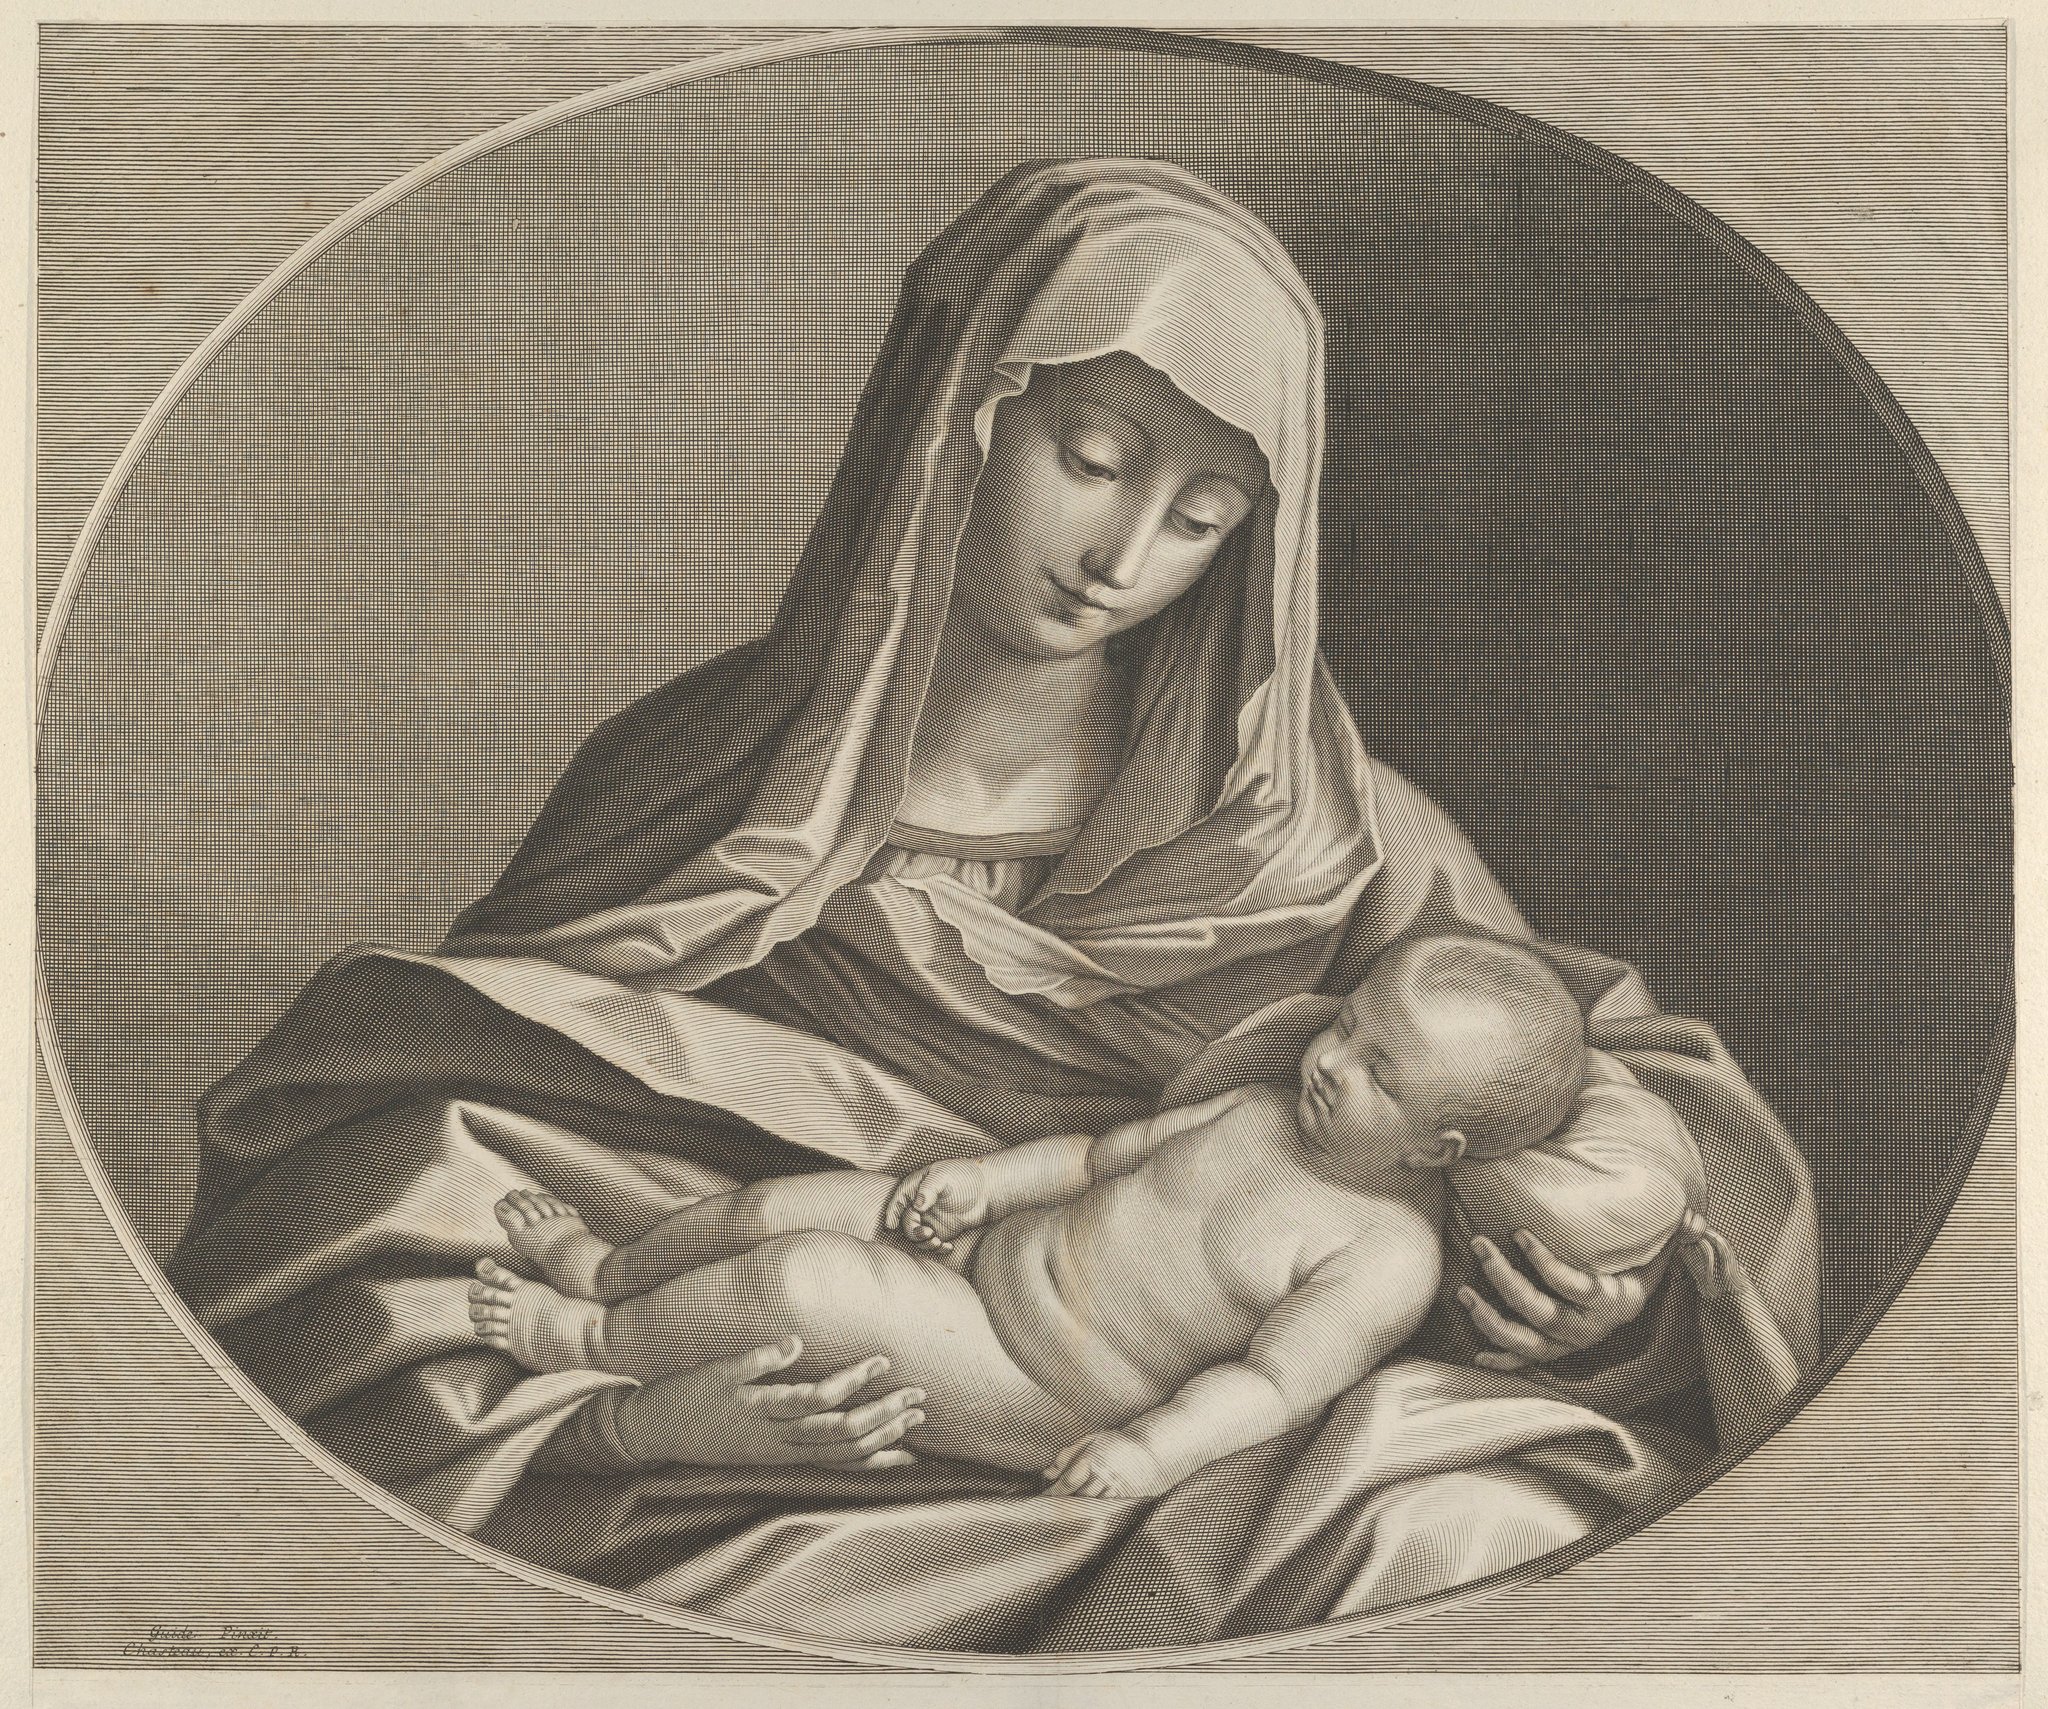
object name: print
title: The Virgin holding the sleeping infant Christ on her lap, after Reni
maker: Anonymous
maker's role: artist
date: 1741-1784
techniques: engraving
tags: madonna and child